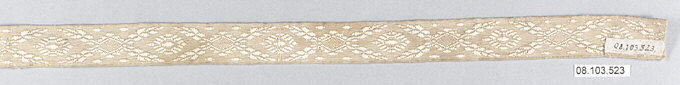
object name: galloon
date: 1701-1900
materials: silk